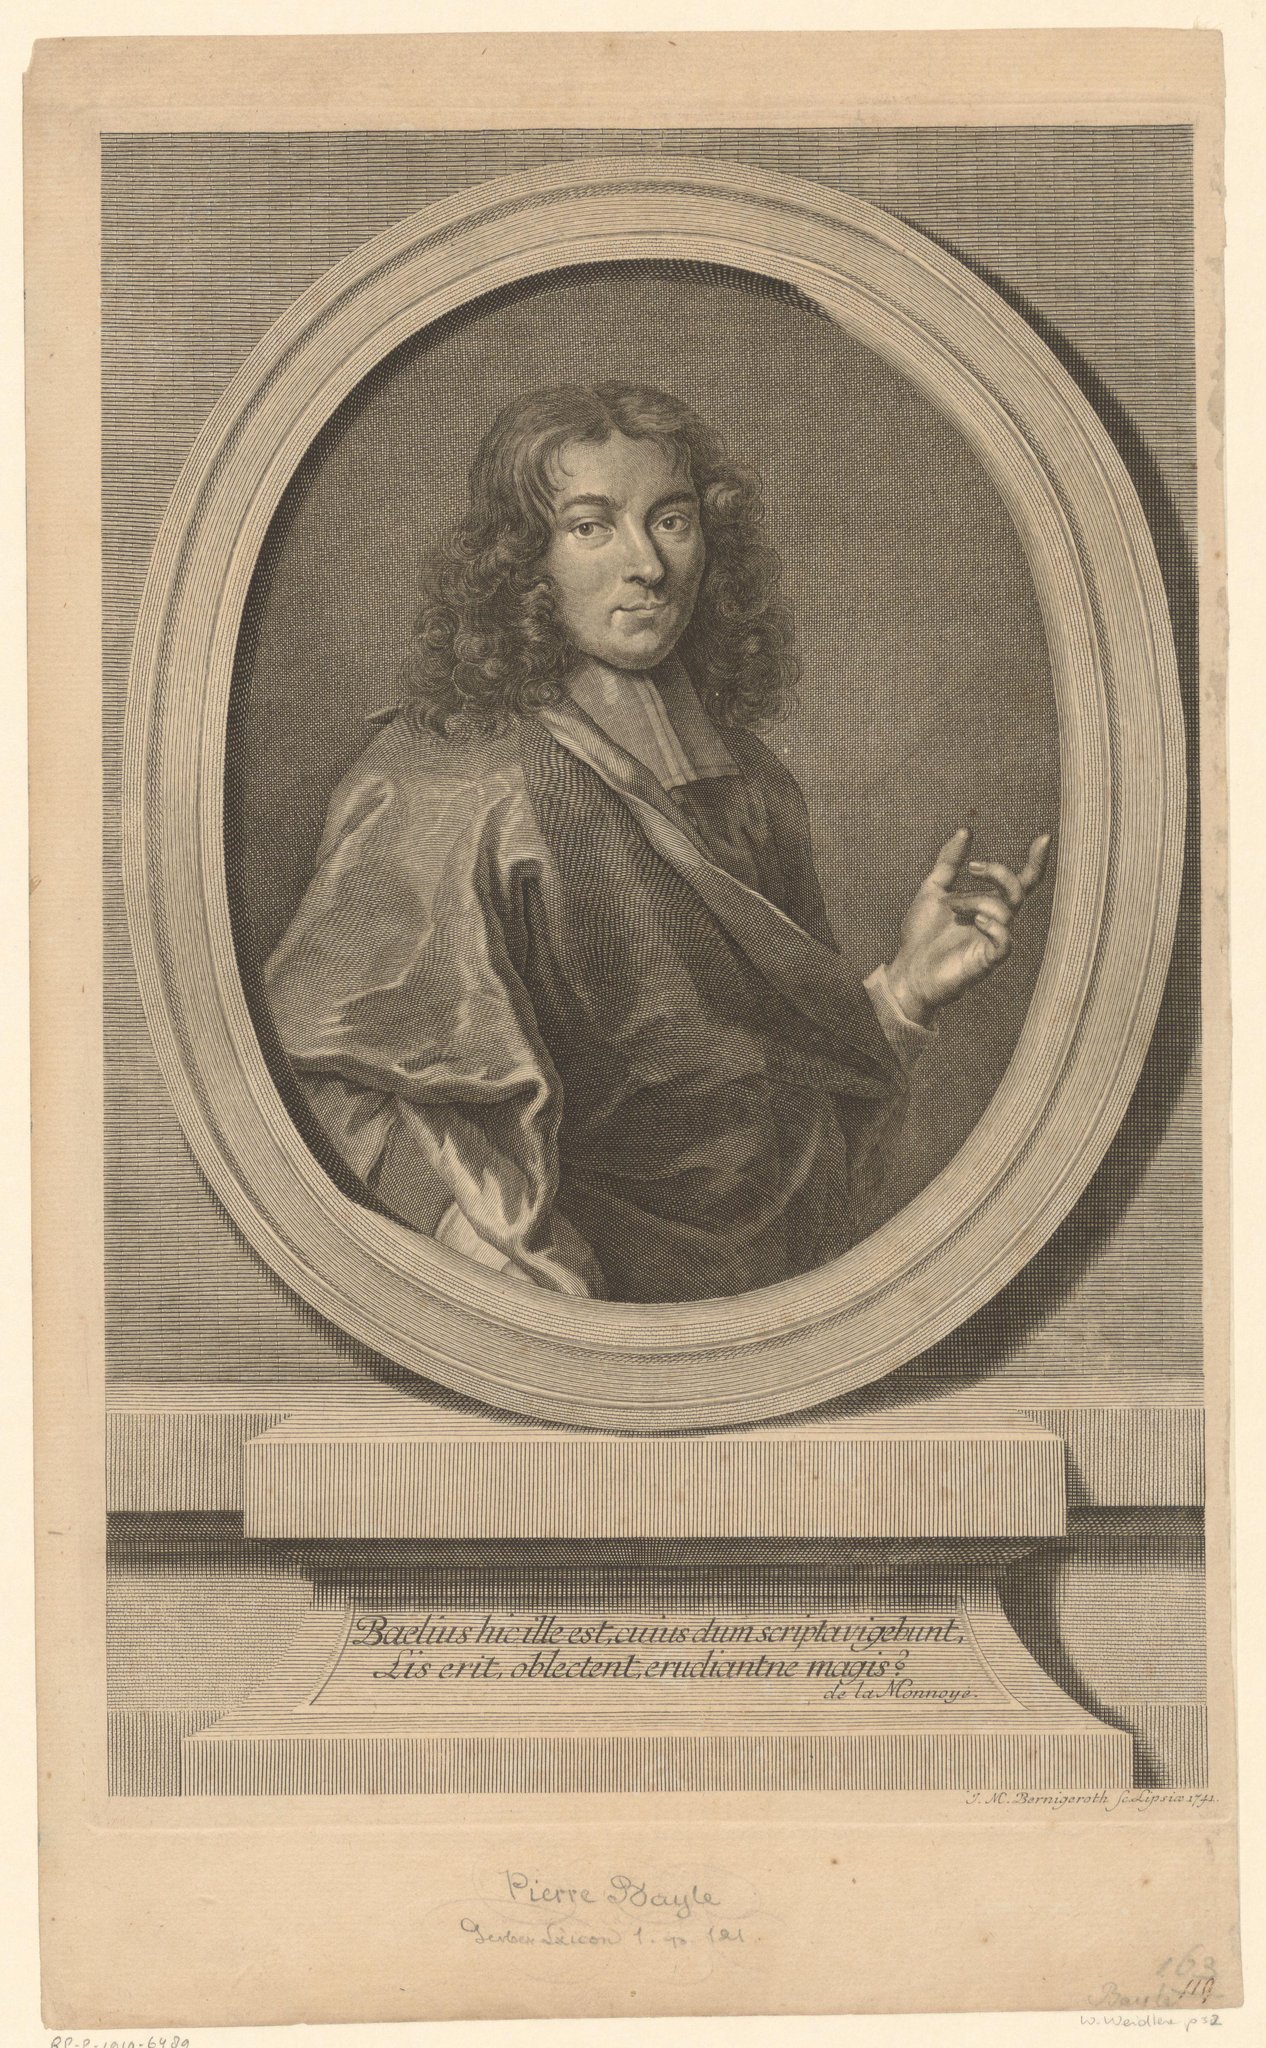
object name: print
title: Portret van Pierre Bayle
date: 1741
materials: paper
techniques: engraving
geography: leipzig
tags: rotterdam, historical persons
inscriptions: collector's mark: Lugt 2228